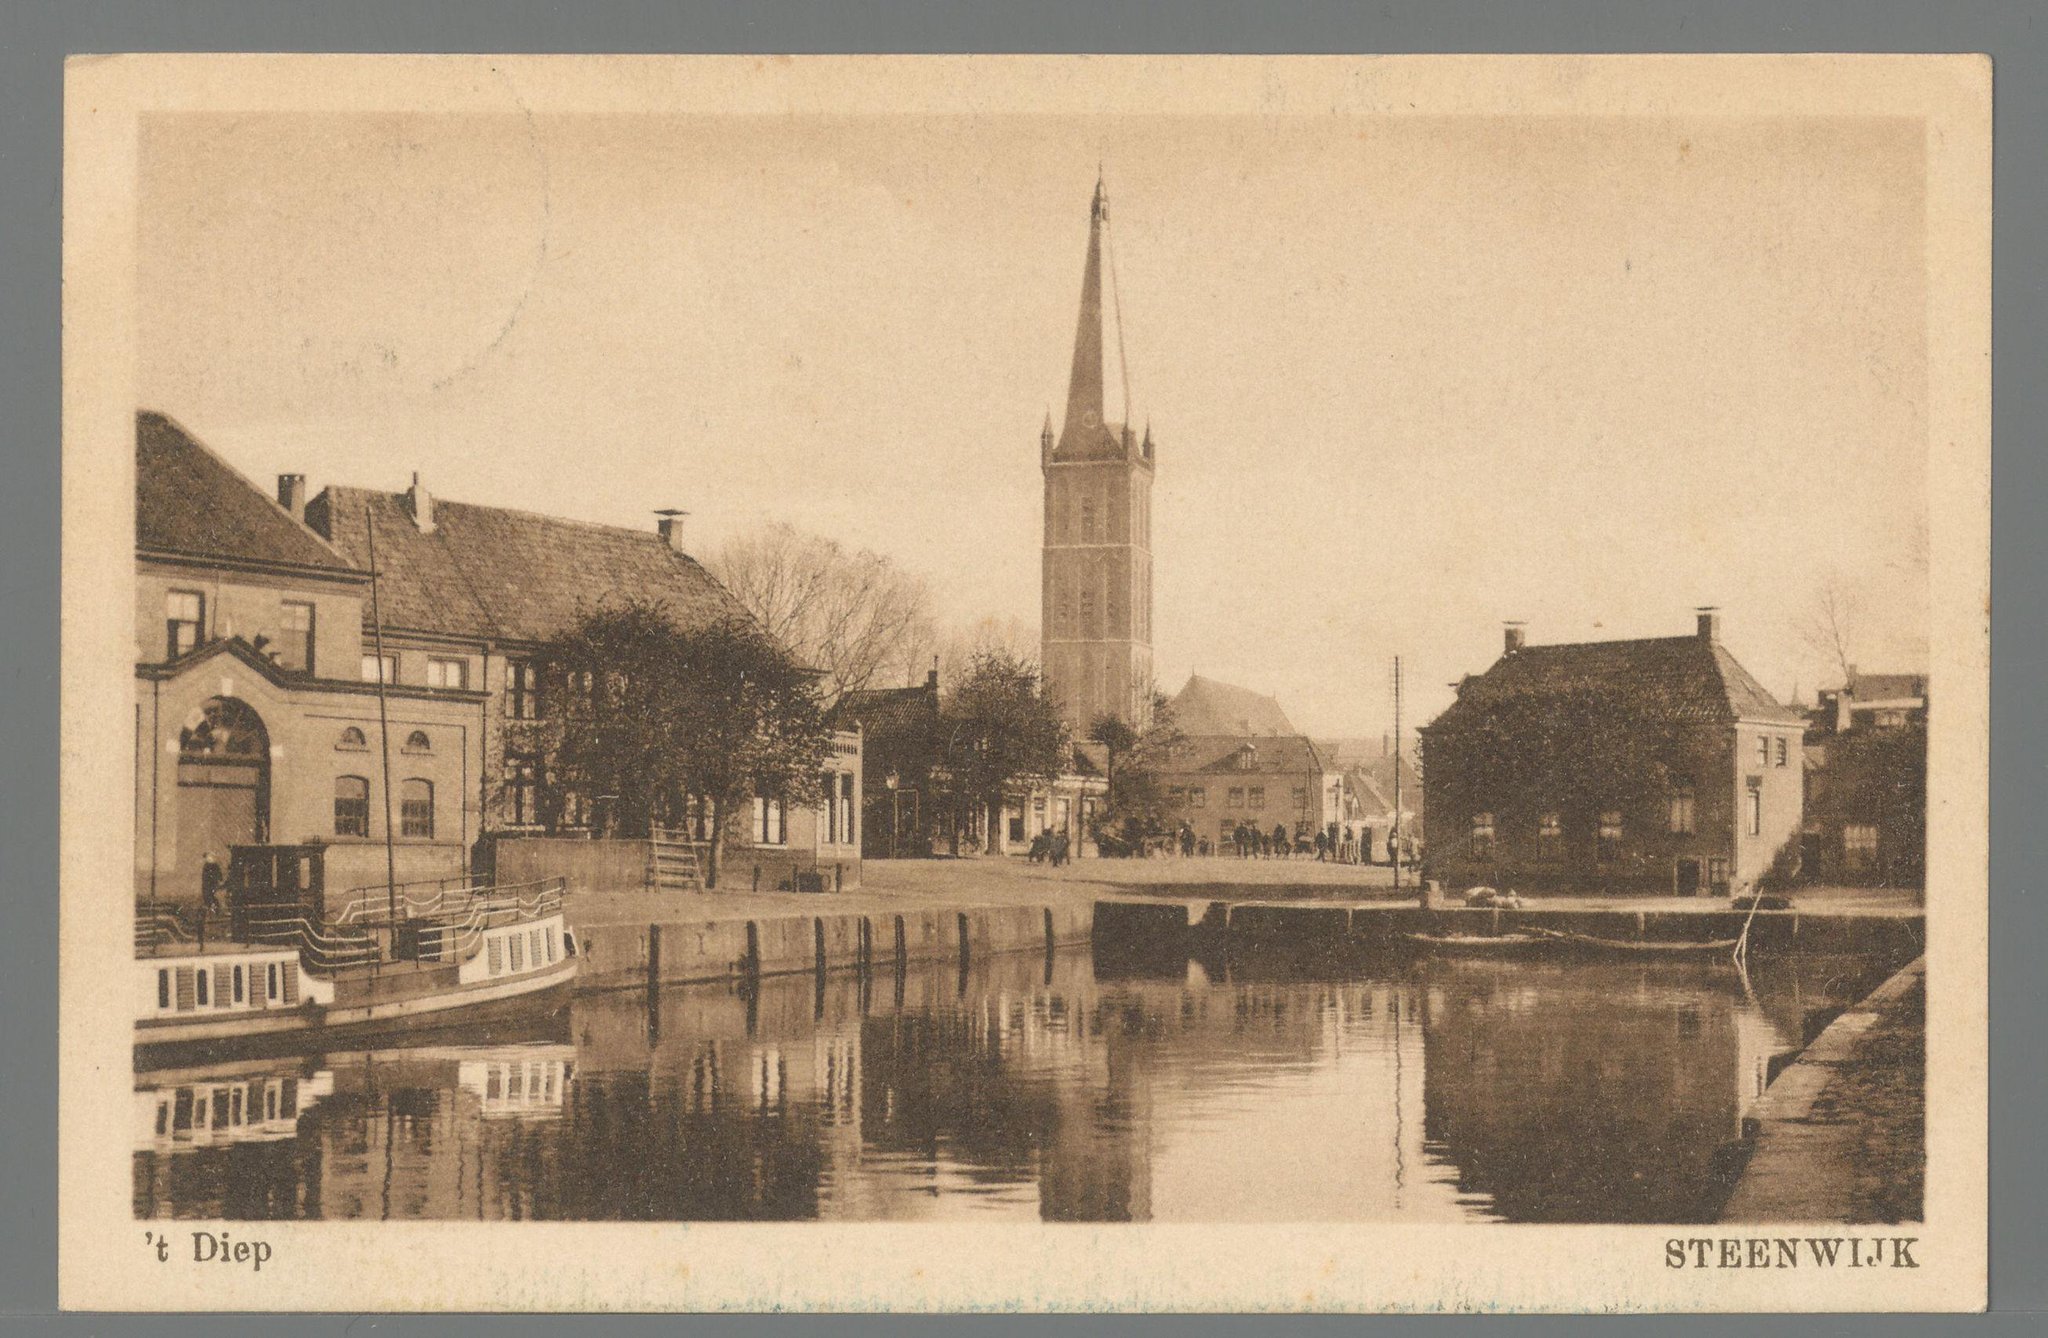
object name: ansichtkaart, prentbriefkaart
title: 't Diep. Steenwijk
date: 1913-1927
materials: cardboard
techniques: photograph, writing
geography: steenwijk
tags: city-view, and landscape with man-made constructions, church (exterior), canals, waters (in city)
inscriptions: postage stamp